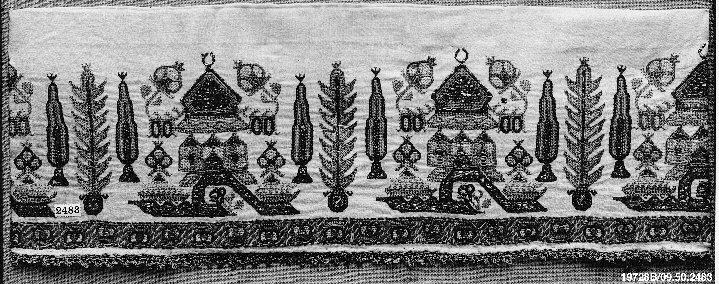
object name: towel end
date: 1801-1900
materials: linen, metal thread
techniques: embroidery, weave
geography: turkey